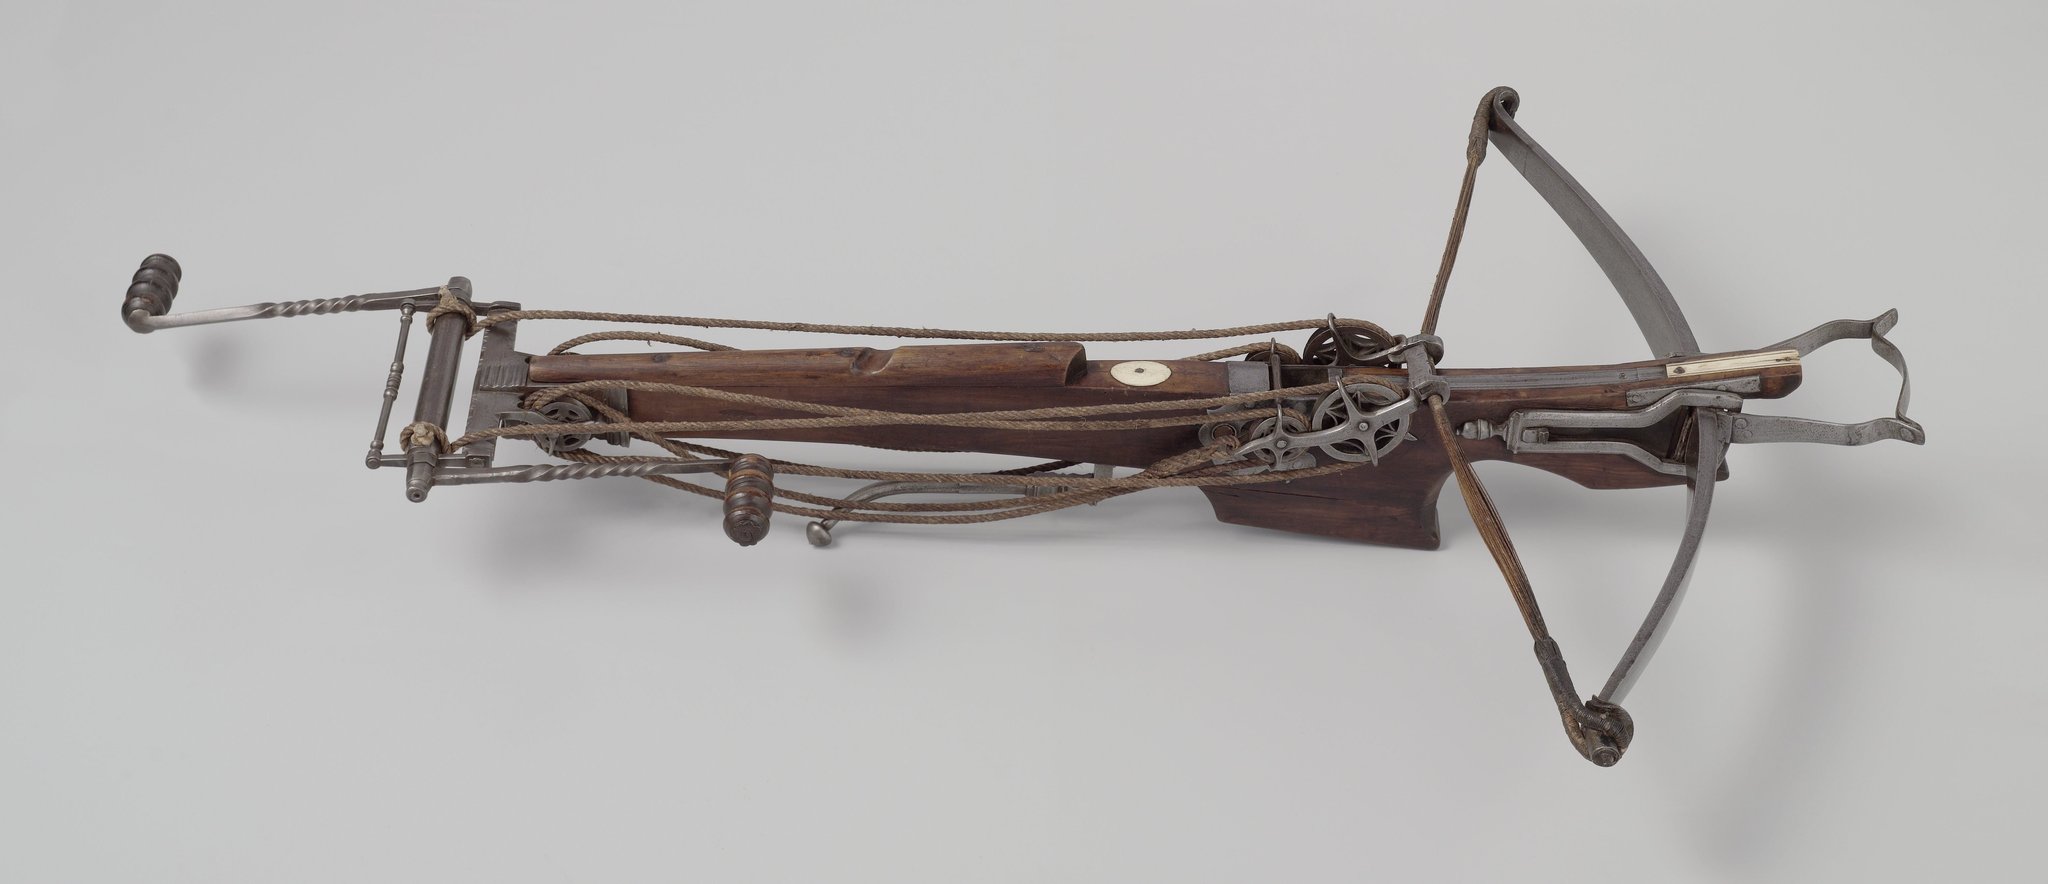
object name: boogspanner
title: Engelse boogspanner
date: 1500-1600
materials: iron, fiber, wood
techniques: forging, riveted, turning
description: Boogspanner bestaande uit twee ijzeren, deels getordeerde, draaiarmen met houten grepen en twee ijzeren katrollen. Dergelijke spanners waren betrekkelijk eenvoudig van de kruisboog los te koppelen. De spanner werd voor het schot van de zuil (het houten centrale deel) afgenomen.